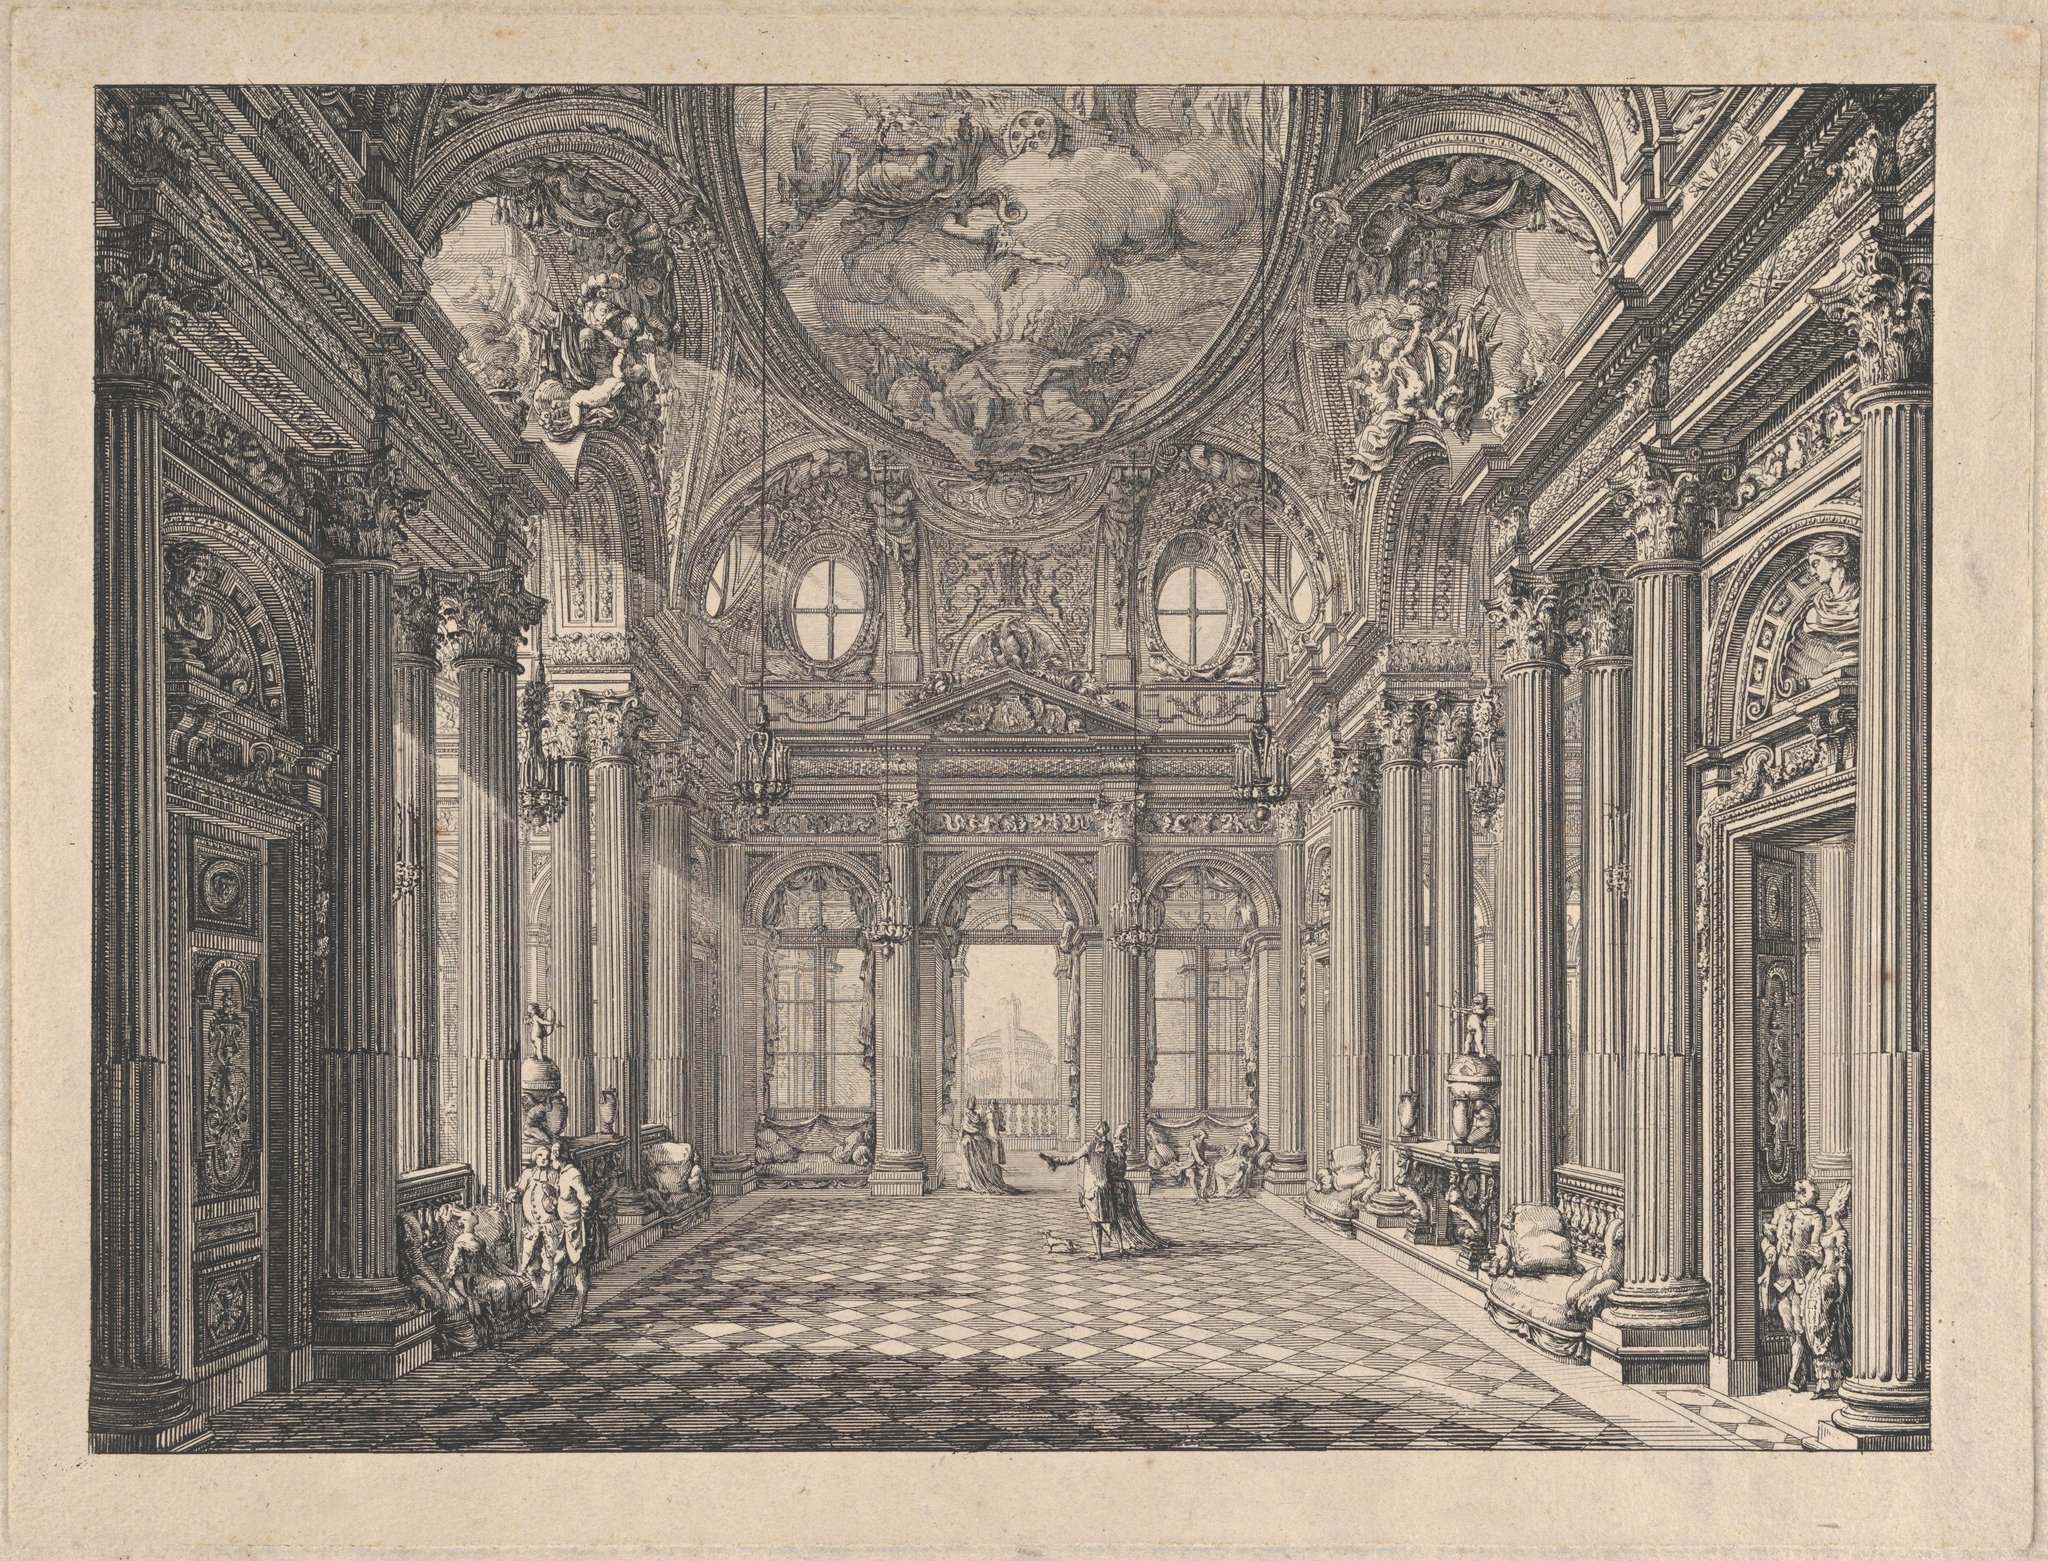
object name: print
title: Interior of the Palazzo Spinola, Genoa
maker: louis jean desprez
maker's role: artist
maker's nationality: french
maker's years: 1743-1804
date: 1777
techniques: etching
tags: architecture,interiors